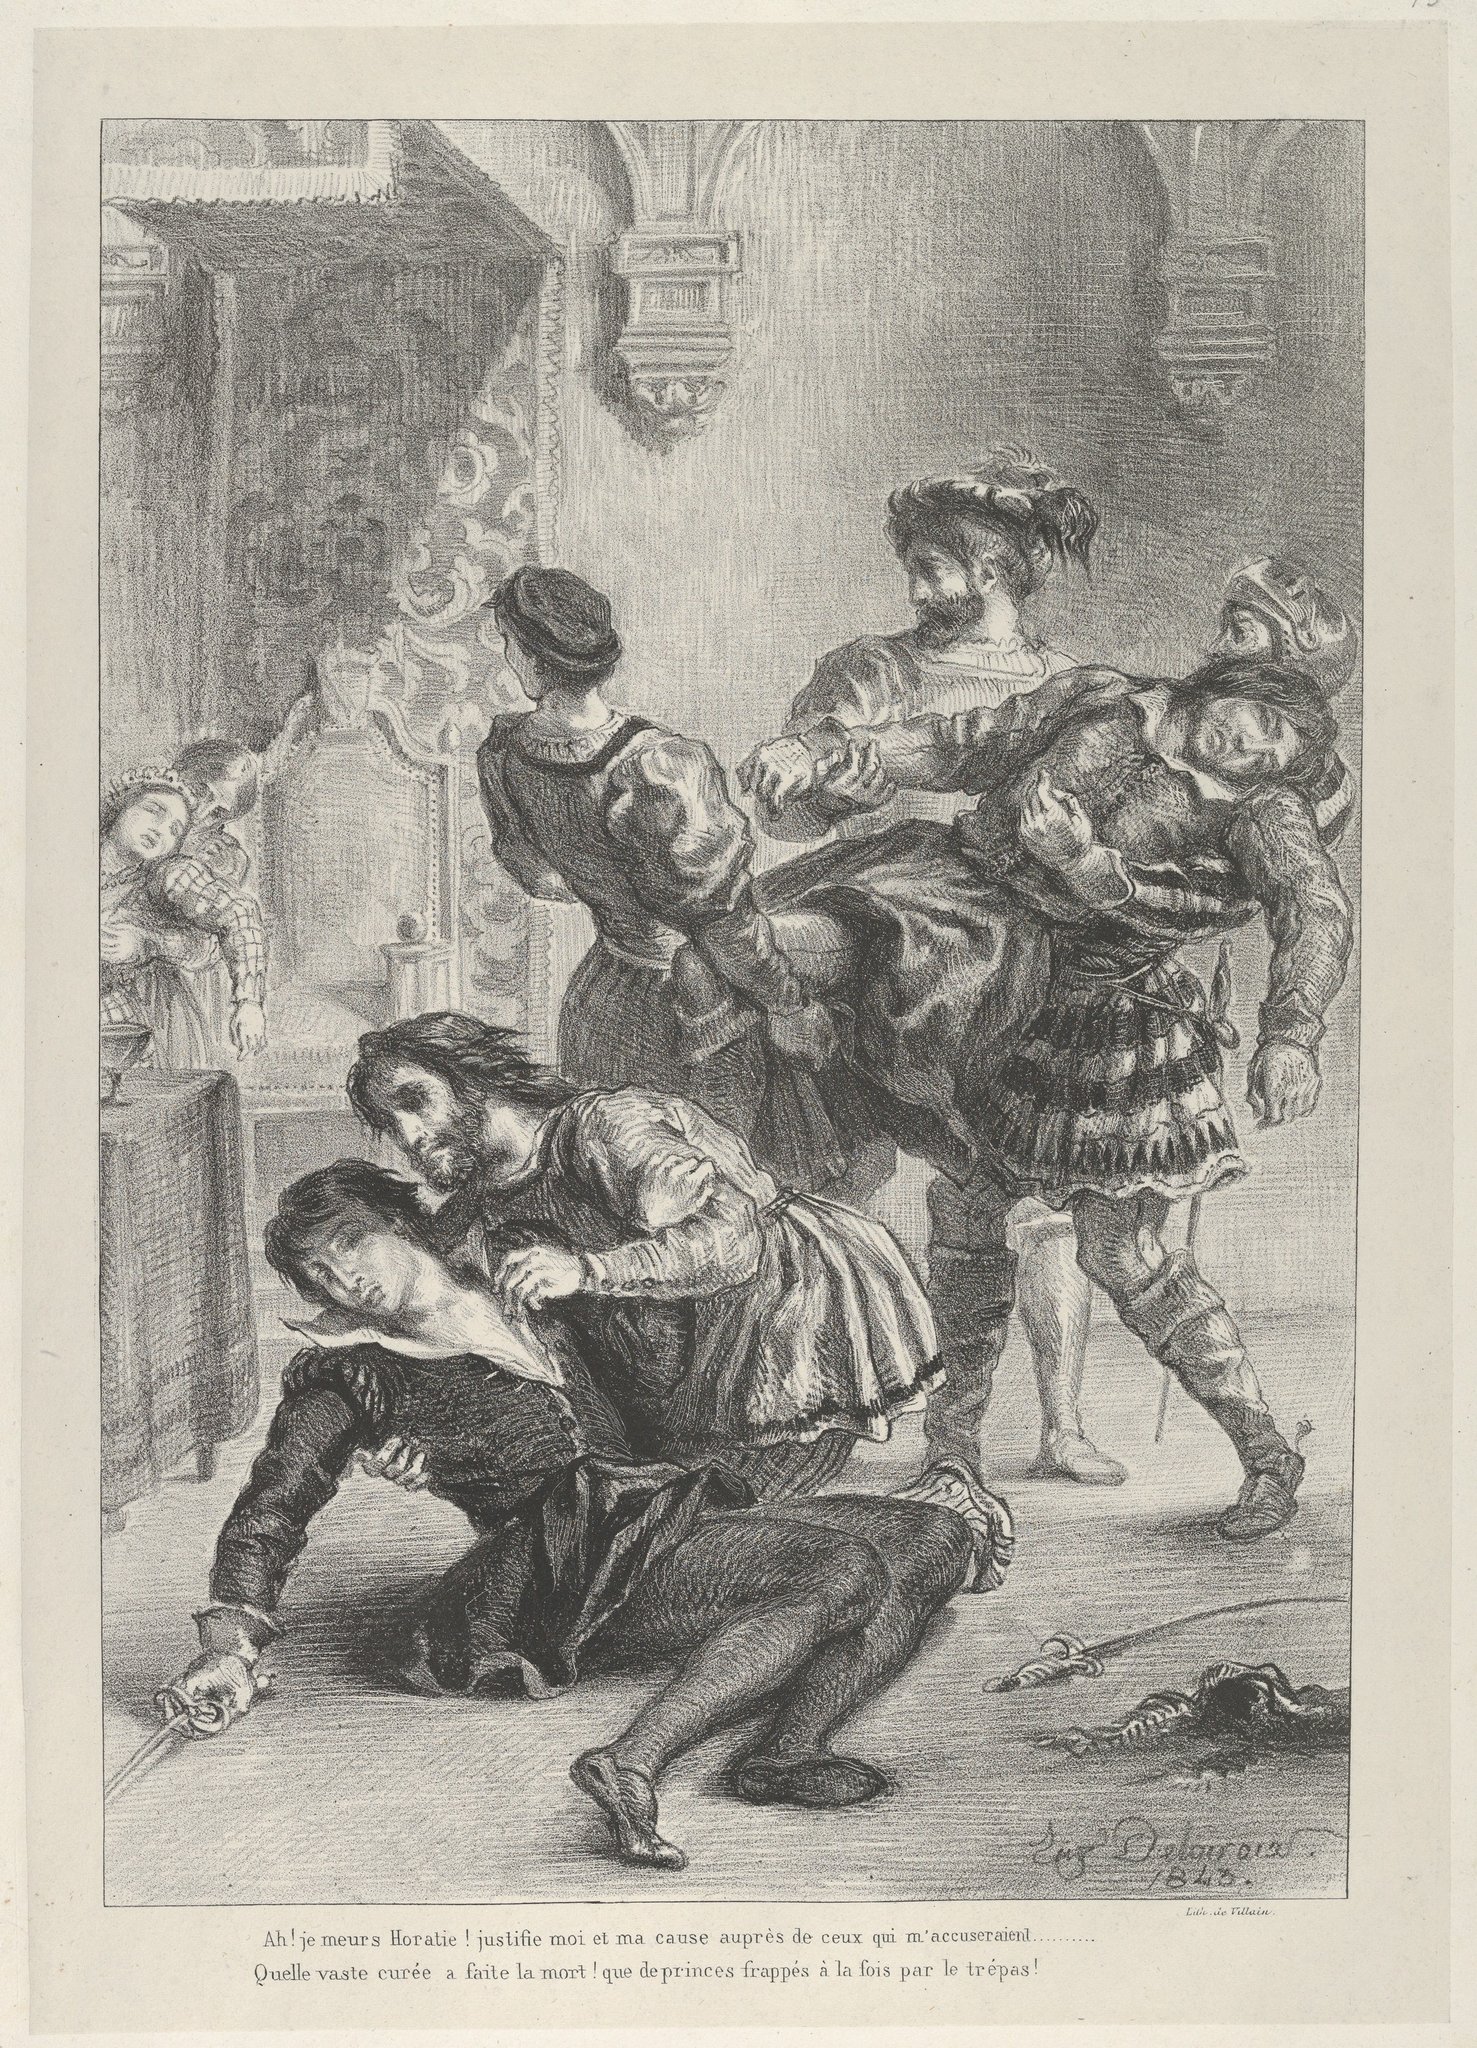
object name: print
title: The Death of Hamlet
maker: eugène delacroix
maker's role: artist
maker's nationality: french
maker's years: 1798-1863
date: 1843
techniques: lithograph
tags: shakespeare,men,women,death,hamlet